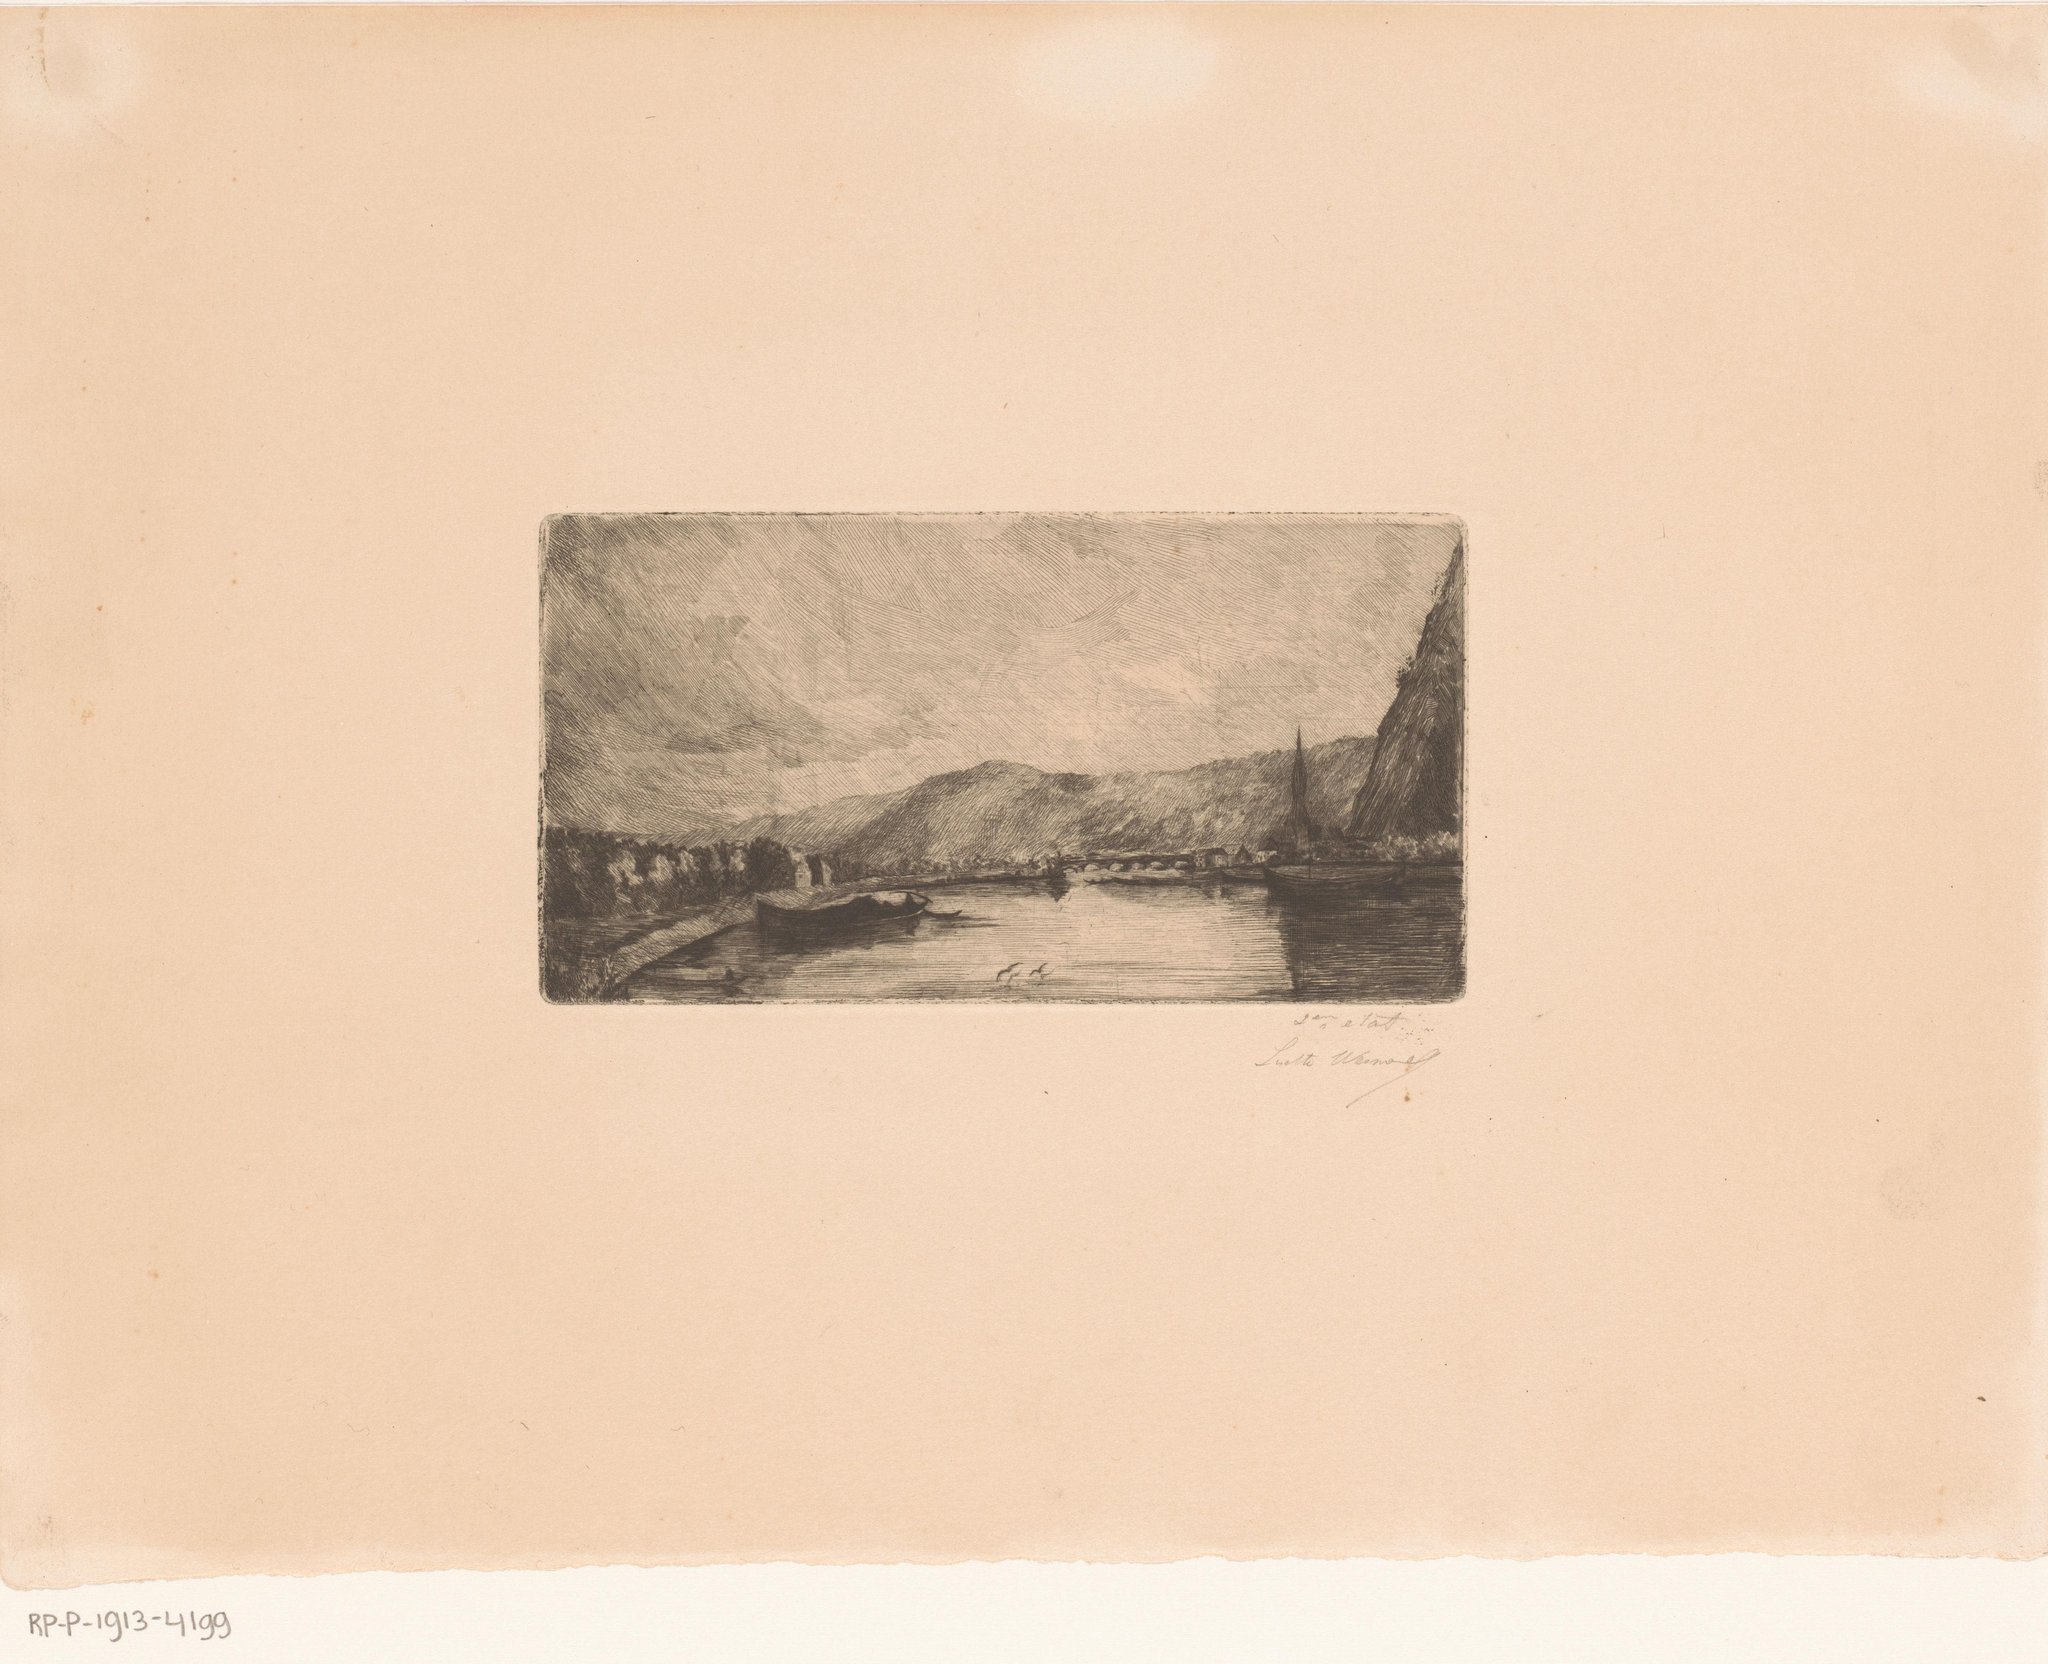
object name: print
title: Berglandschap met dorp aan water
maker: lisette wesmael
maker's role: print maker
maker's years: 1861-1953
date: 1887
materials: paper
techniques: drypoint, etching, intaglio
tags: landscapes with waters, waterscapes, seascapes (in the temperate zone), mountains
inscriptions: collector's mark: Lugt 2228